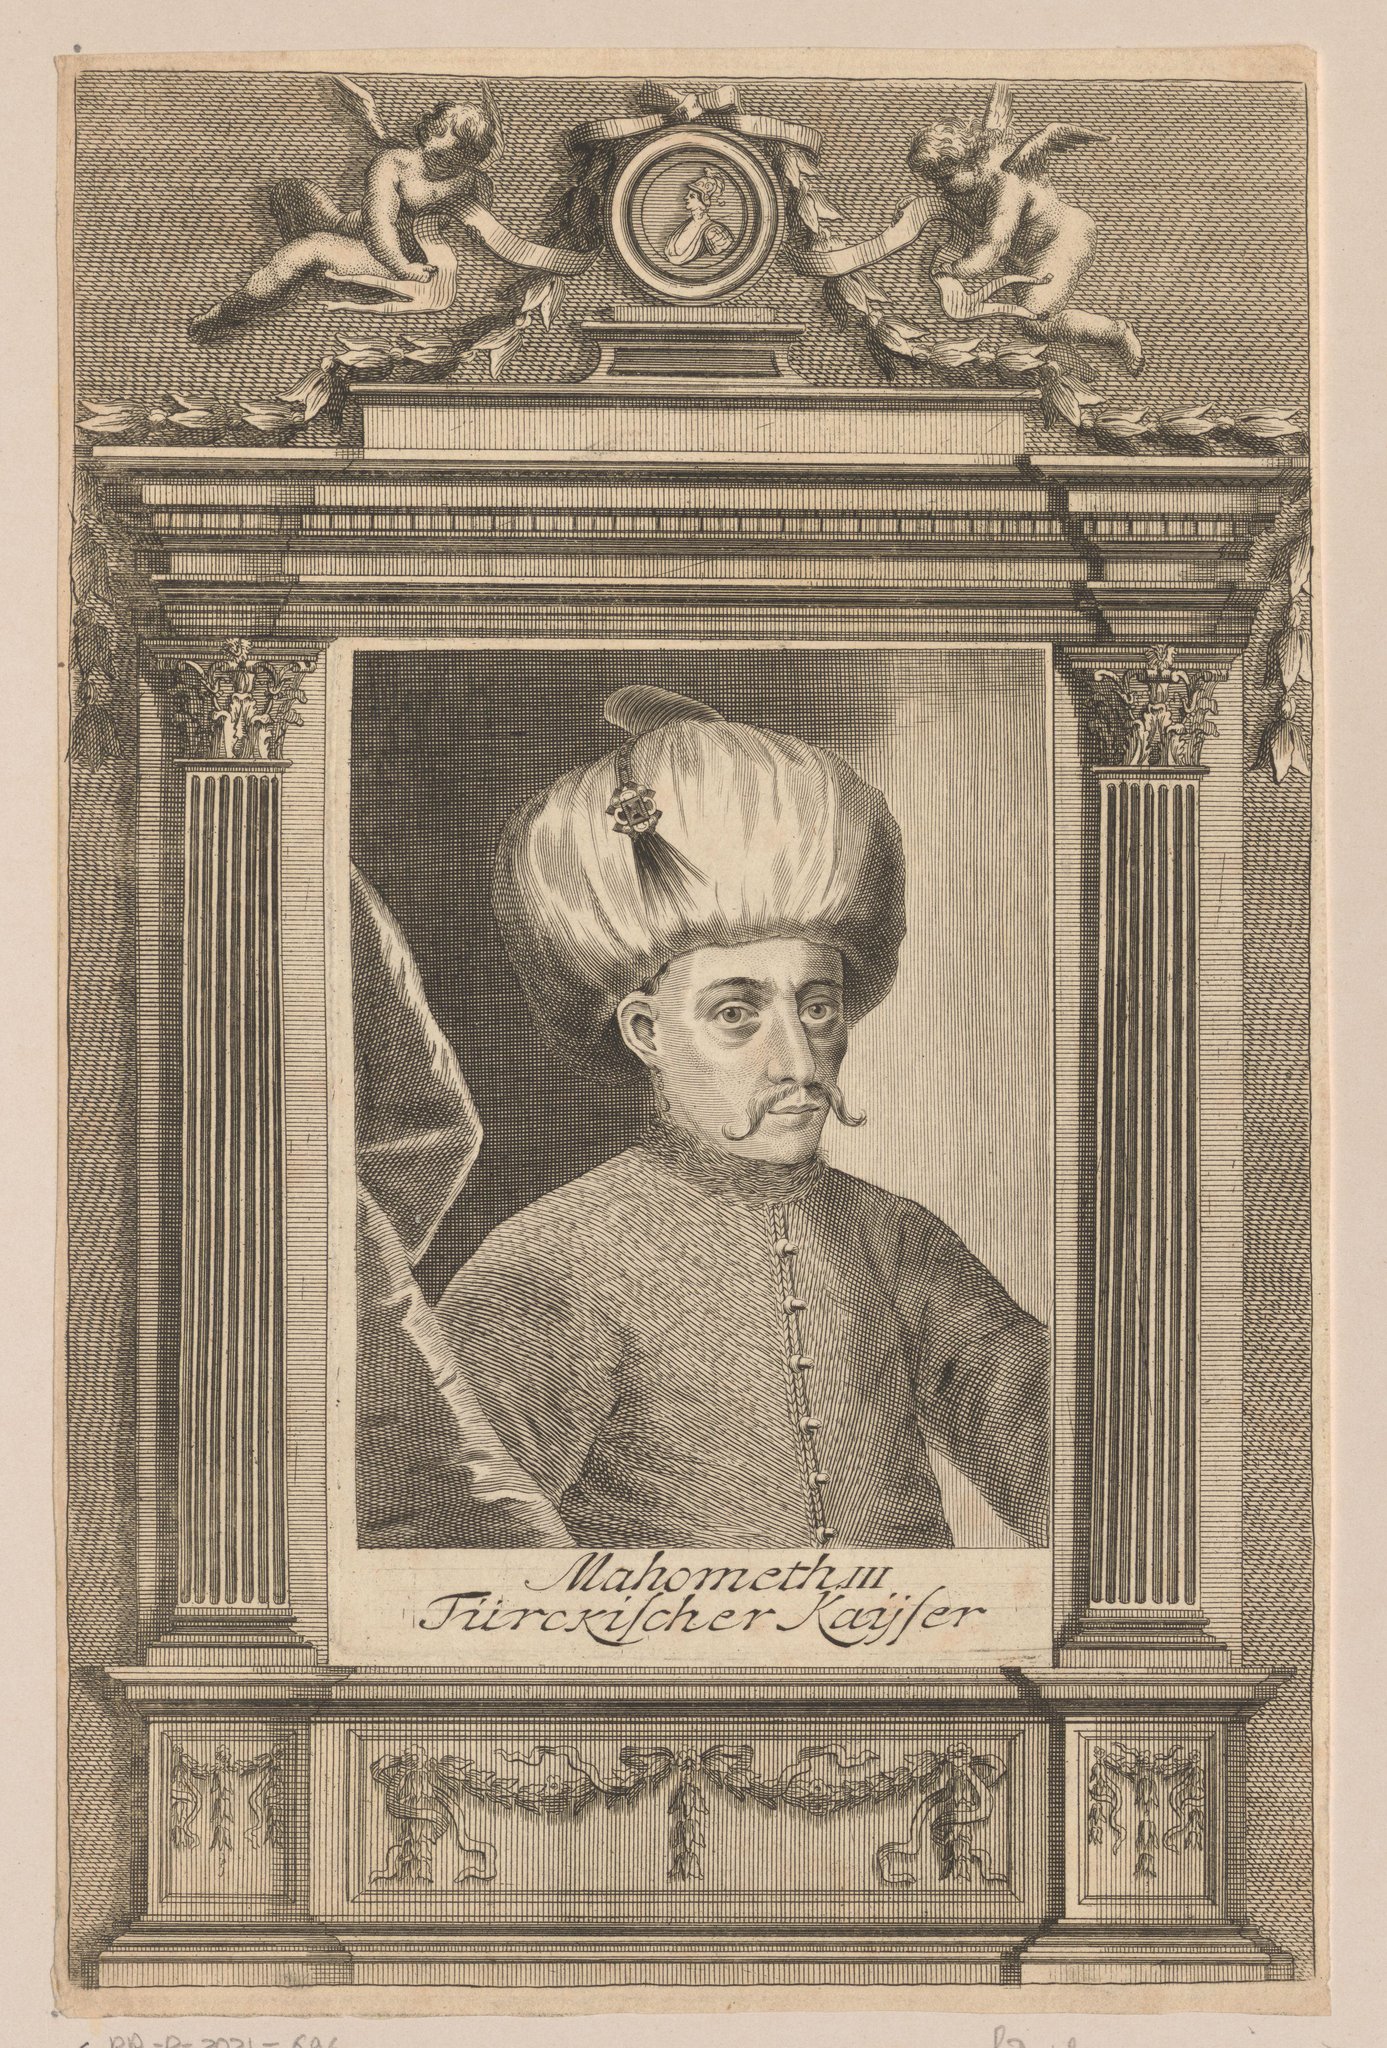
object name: print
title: Portret van Mehmet III, sultan van het Ottomaanse Rijk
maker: Anonymous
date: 1592-1650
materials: paper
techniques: engraving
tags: historical persons, head-gear: turban, ruler, sovereign